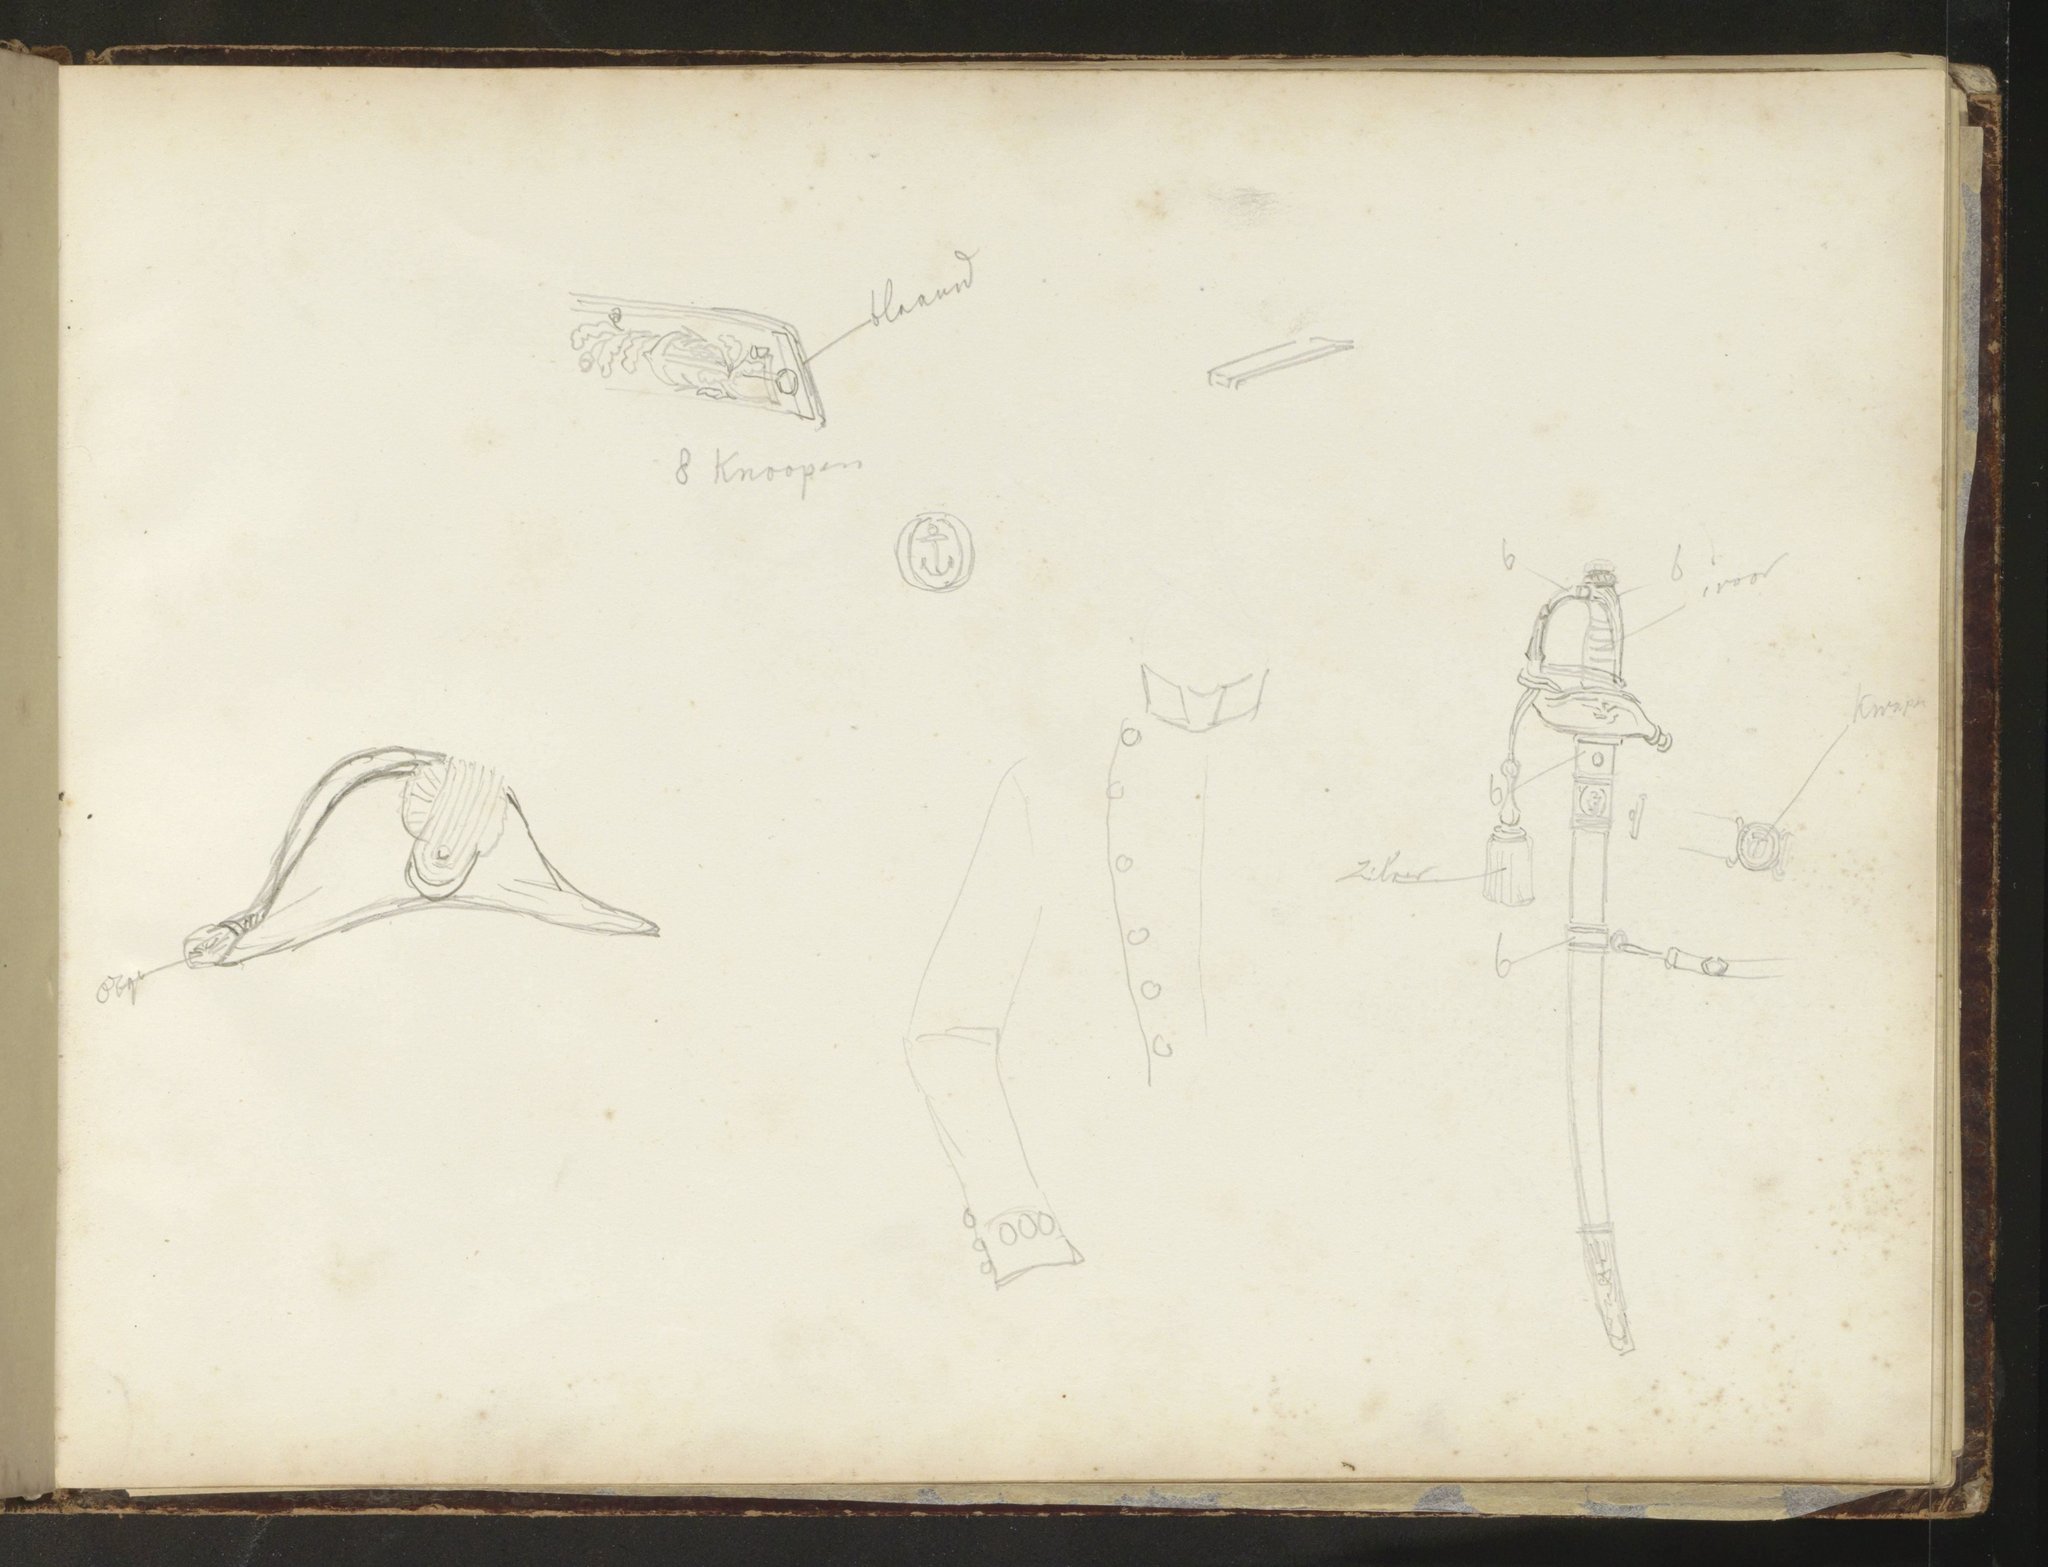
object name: sketchbook leaf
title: Helm, jas met knopen, een boord en een zwaard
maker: reinier craeyvanger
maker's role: draughtsman, print maker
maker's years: 1812-1880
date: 1822-1880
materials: paper, pencil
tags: helmet, hacking and thrusting weapons: sword, coat, cape, neck-gear: collar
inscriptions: kleurnotitie, handgeschreven in potlood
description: Blad 20 recto uit een schetsboek met 45 bladen.